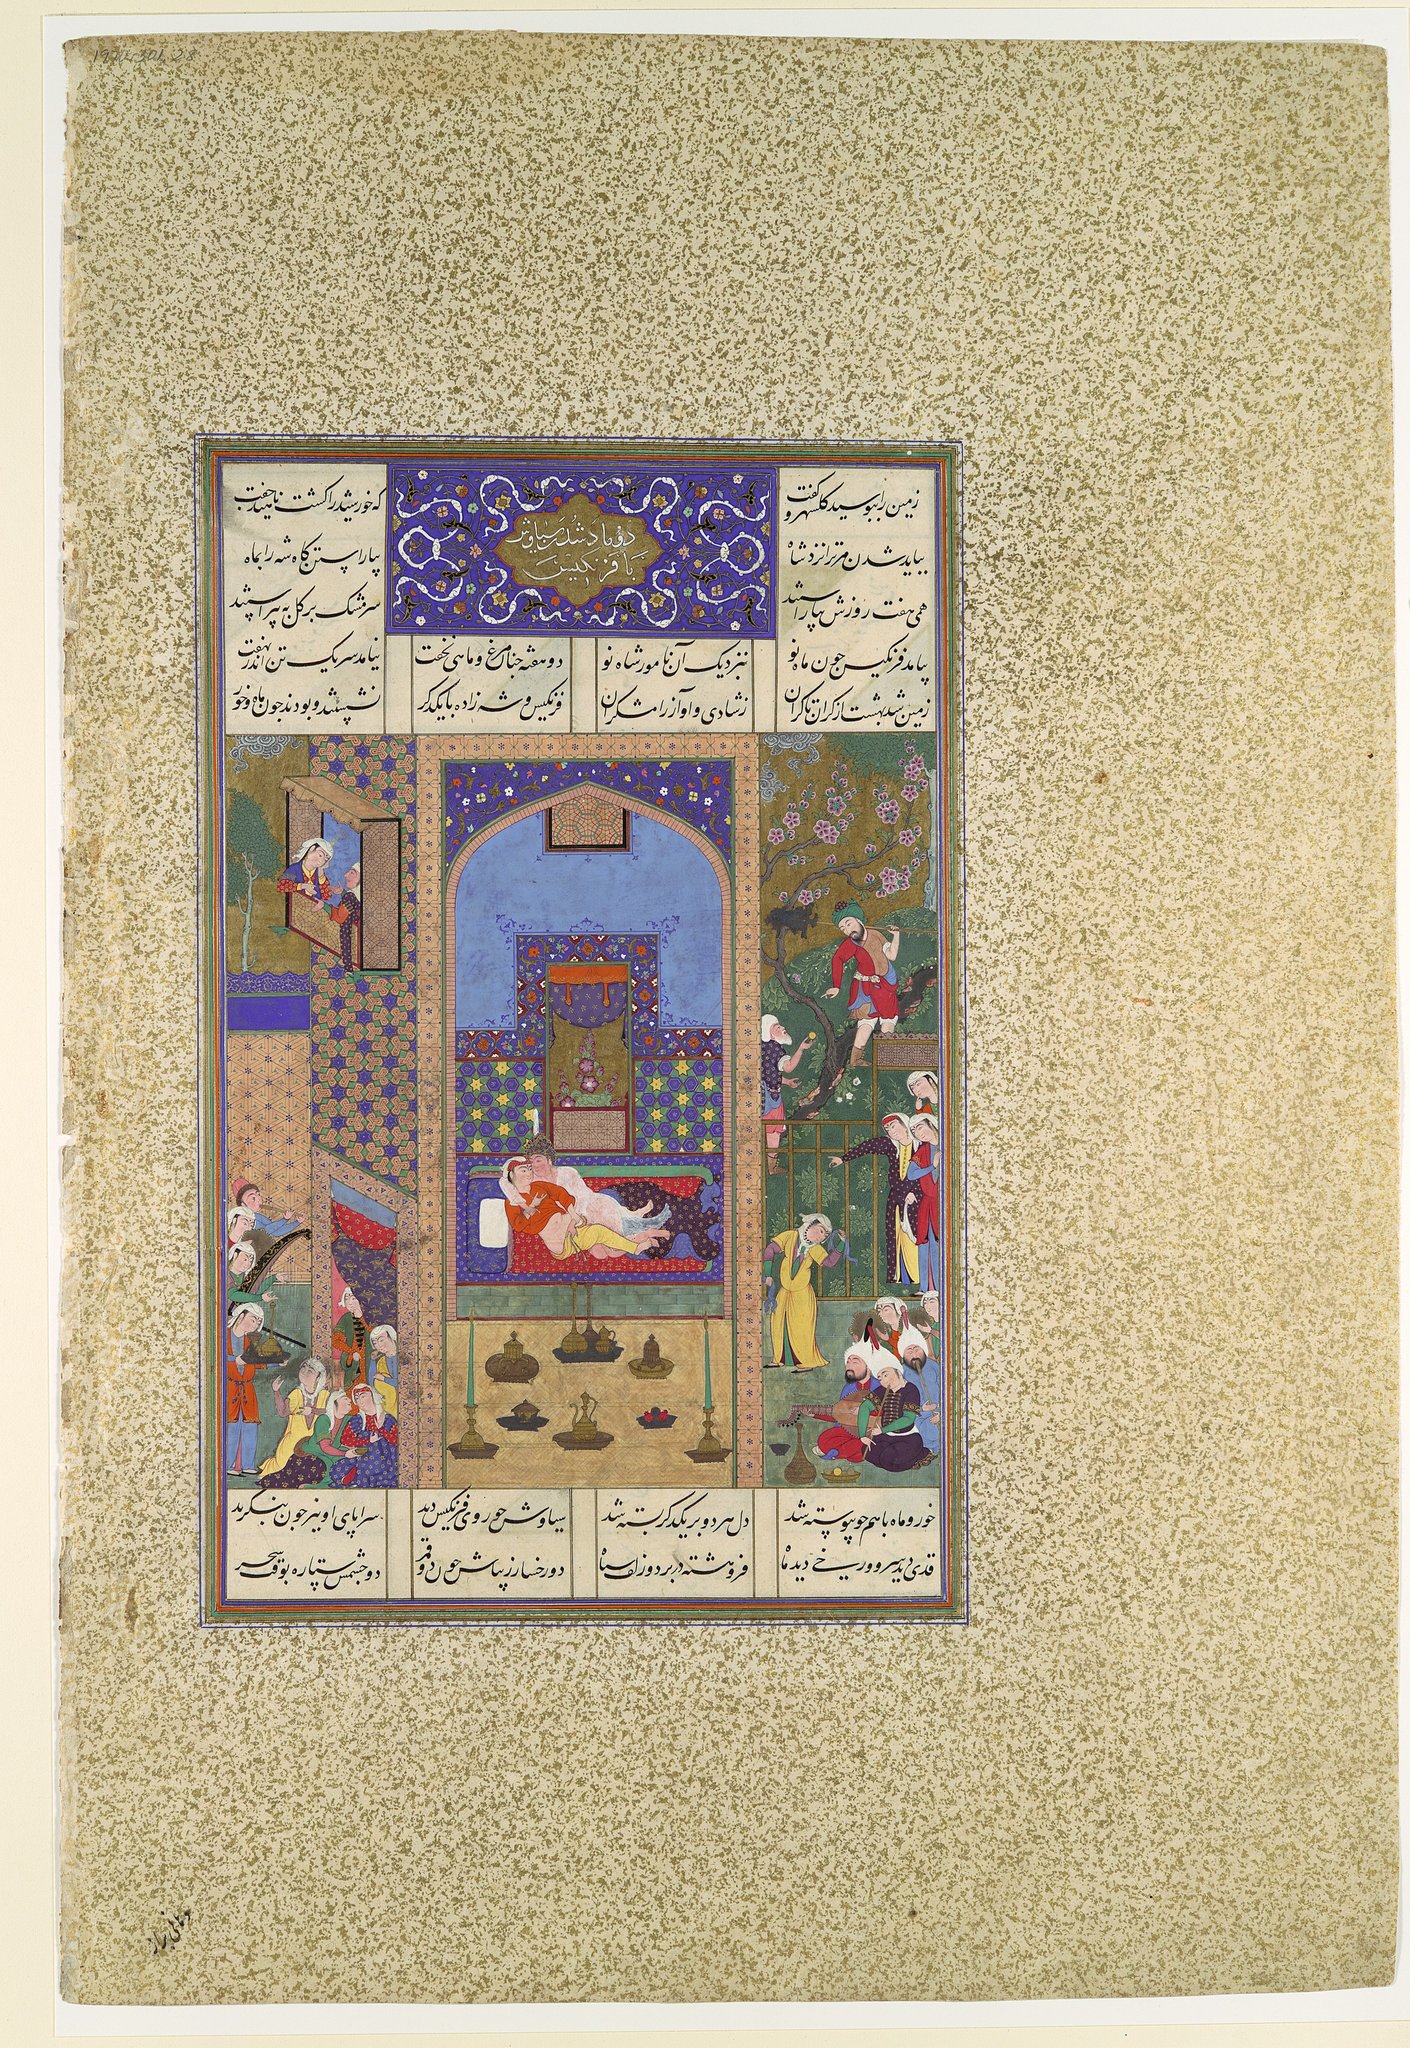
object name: folio from an illustrated manuscript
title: "The Wedding of Siyavush and Farangis", Folio 185v from the Shahnama (Book of Kings) of Shah Tahmasp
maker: abu'l qasim firdausi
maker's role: author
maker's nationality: iranian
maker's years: 935-1020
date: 1525-1530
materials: gold, ink, paper, silver, watercolor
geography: iran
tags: musical instruments,couples,men,women,musicians